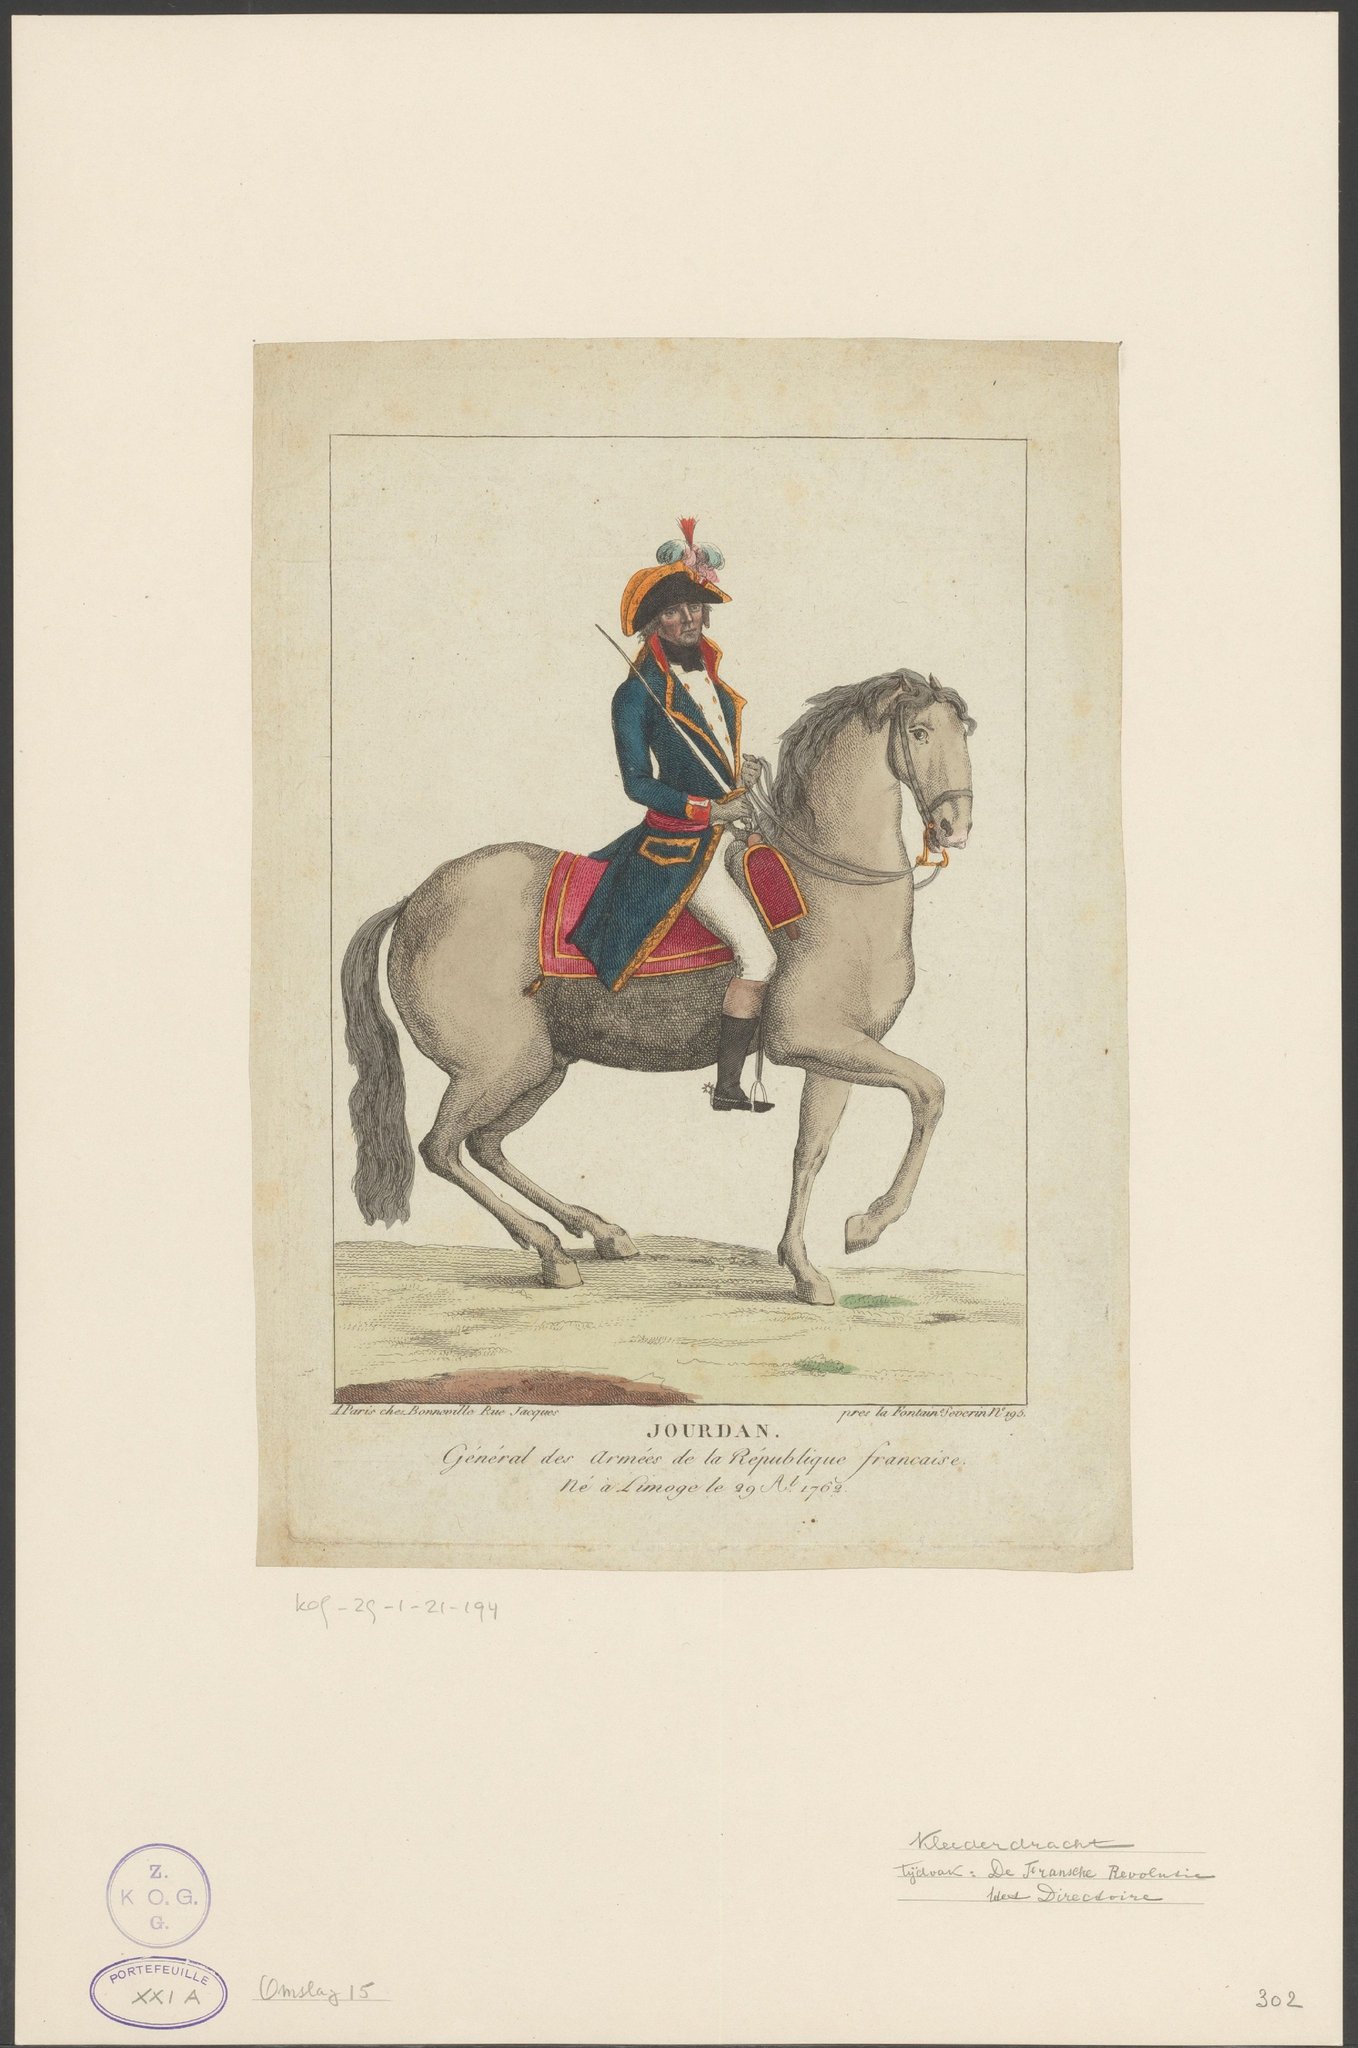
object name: print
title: Portret van Jean-Baptiste Jourdan te paard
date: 1795-1800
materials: paper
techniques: engraving, etching, hand coloring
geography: paris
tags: paris, politician, riding a horse, ass, or mule; rider, horseman, banner, standard (as symbol of the state, etc.), horse, commander-in-chief, admiral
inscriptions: stamp, collector's mark: Lugt 1641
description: Onderwerpsrubrieken binnen de Atlas Zeden en Gewoonten: Zeden en Gewoonten in Engeren Zin, De Kleeding, Kleederdrachten (tijdvakken), De Fransche Revolutie. (Het Directoire).